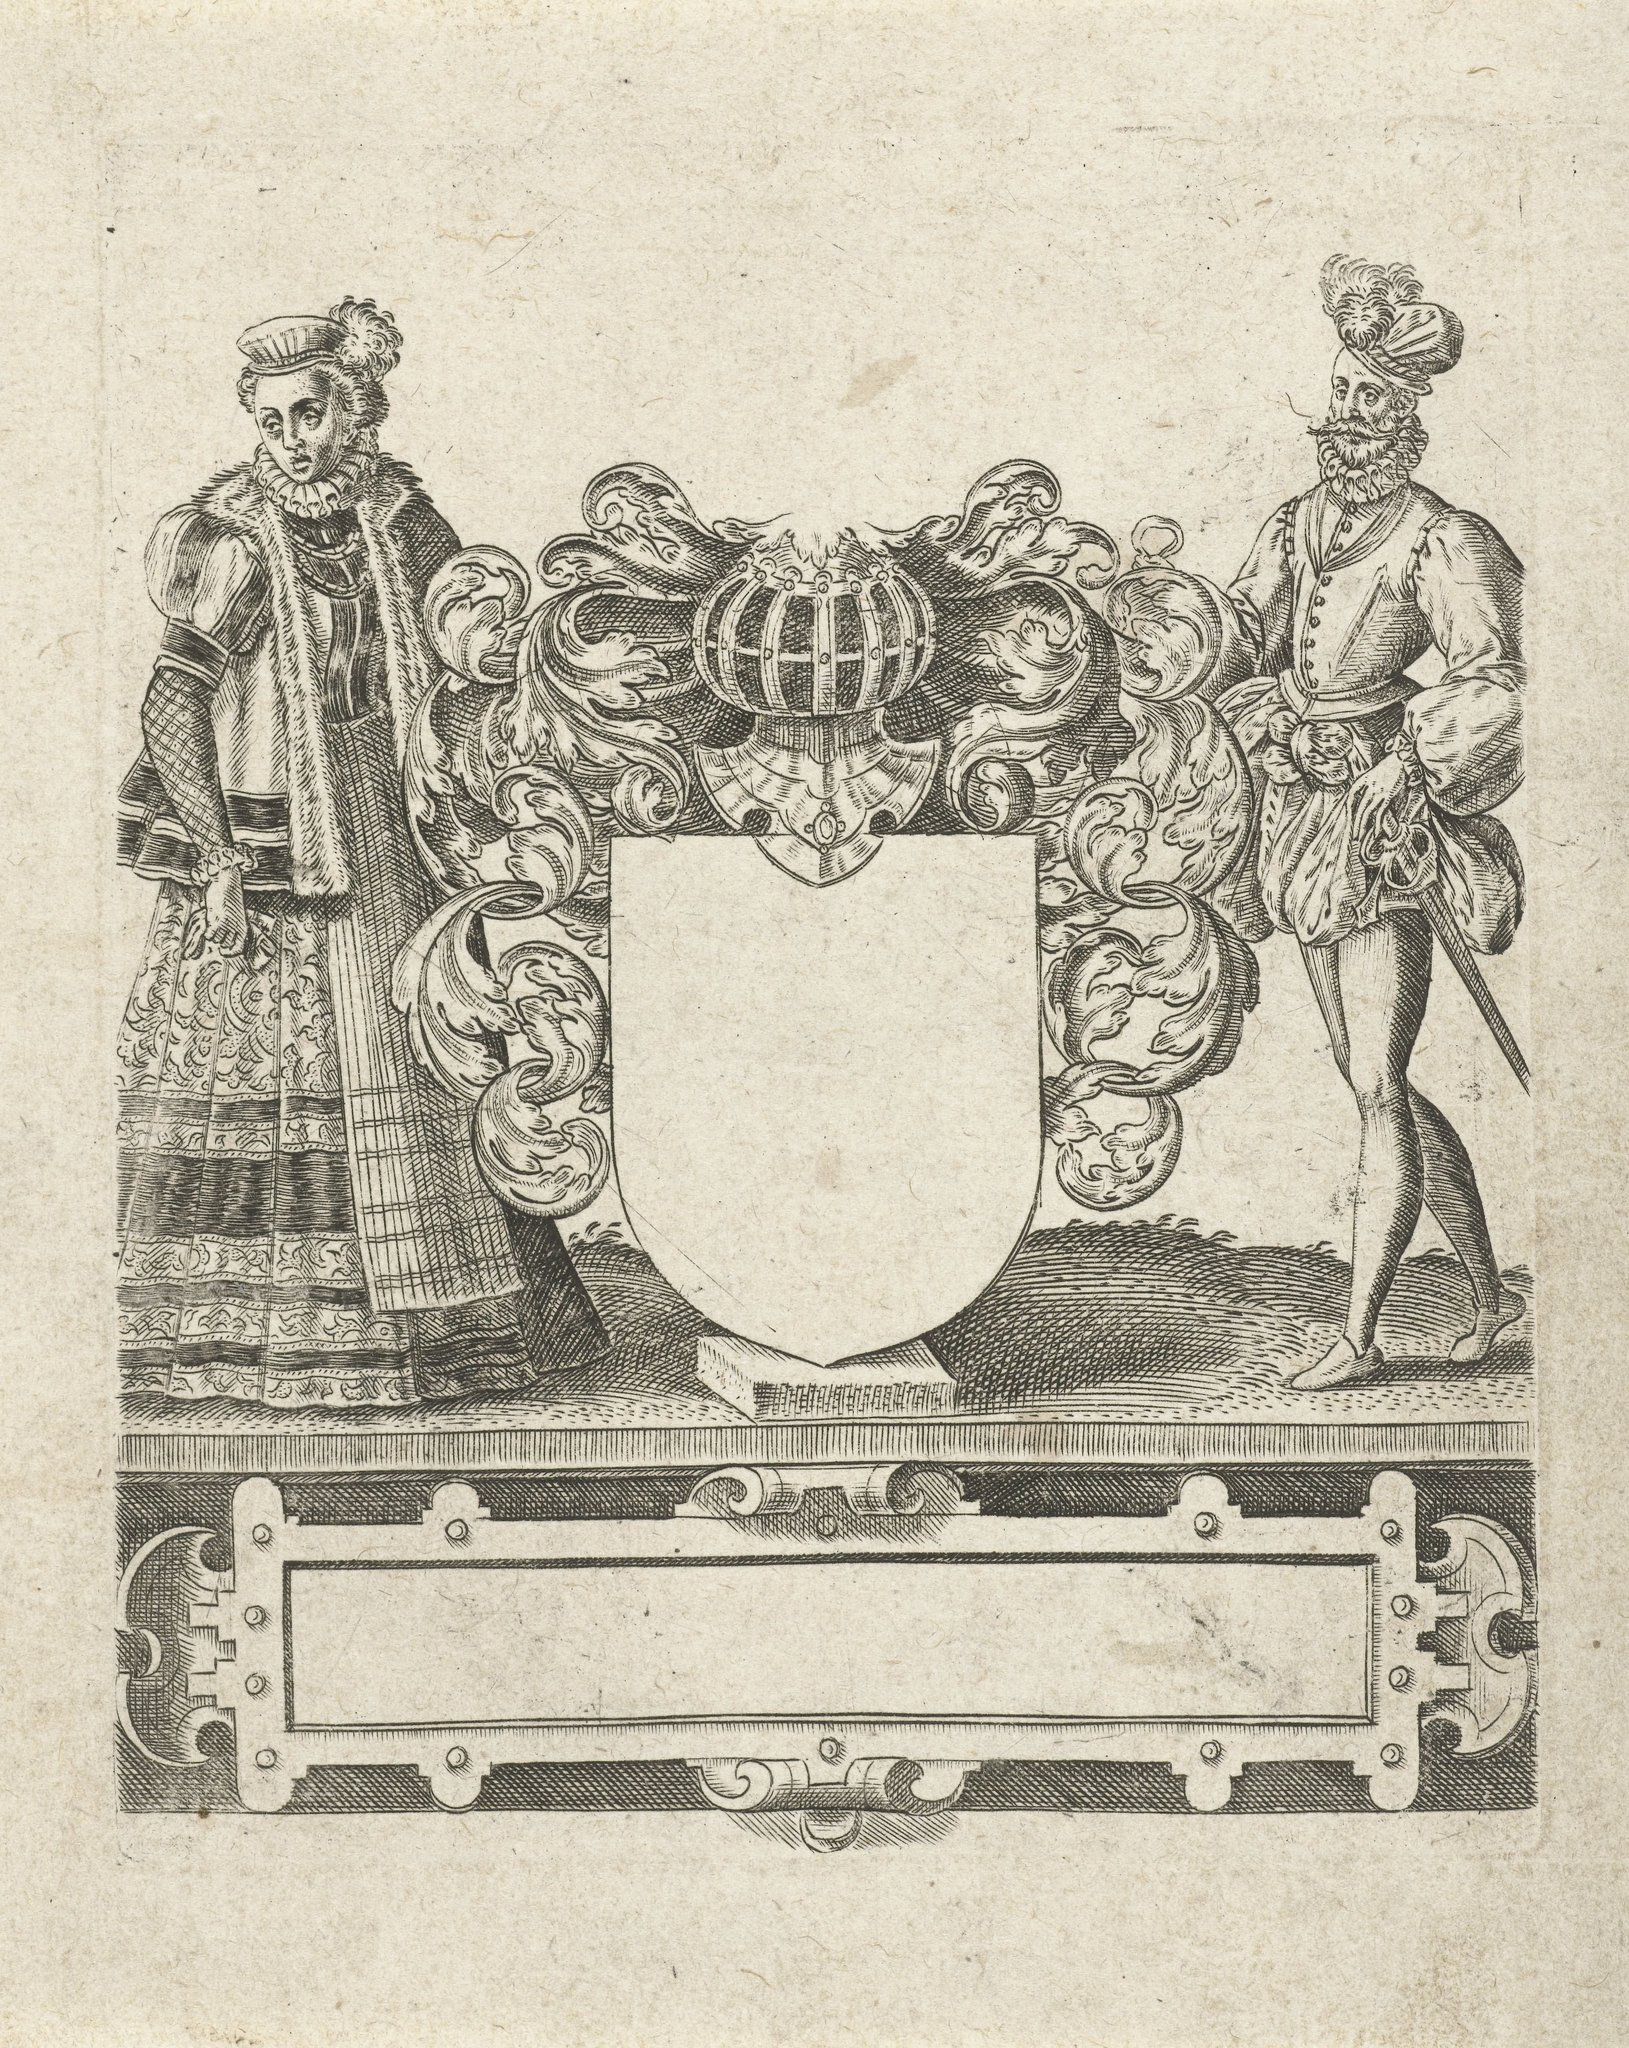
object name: print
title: Leeg wapenschild met man en vrouw als schildhouders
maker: abraham de bruyn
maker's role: print maker, publisher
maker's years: 1540-1587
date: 1550-1587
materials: paper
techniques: engraving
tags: armorial bearing, heraldry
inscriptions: collector's mark: Lugt 2228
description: Leeg wapenschild met versieringen. Langs beide kanten een man en een vrouw in adellijke kledij